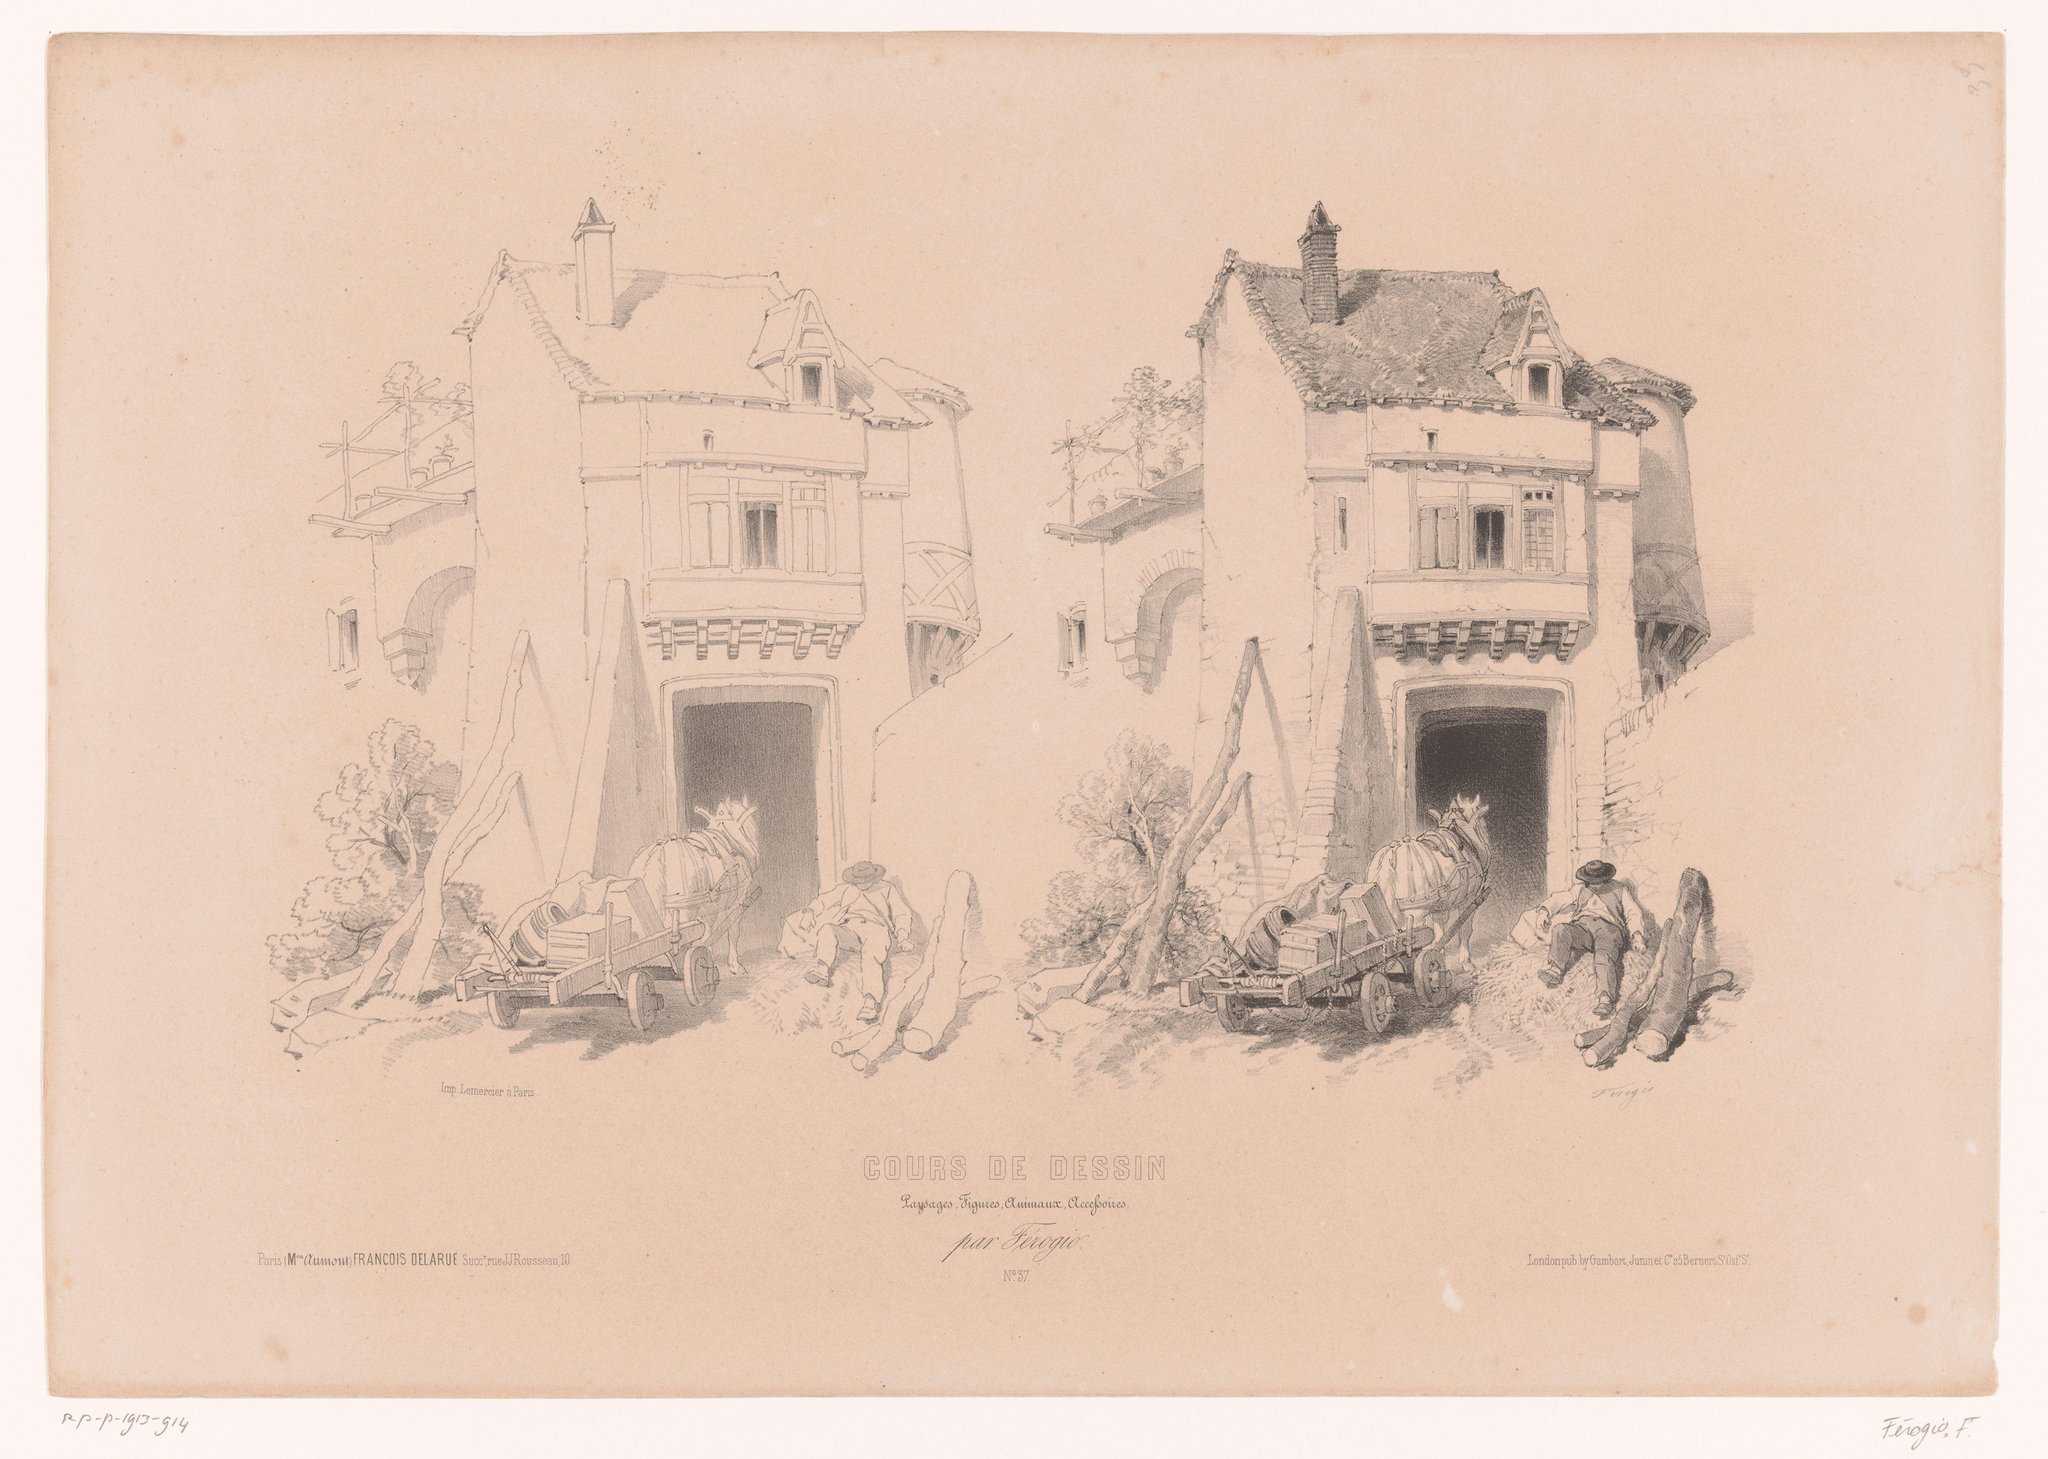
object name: print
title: Vrachtrijder met paard en wagen rust bij een poort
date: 1845-1846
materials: paper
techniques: lithograph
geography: london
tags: riding a horse, ass, or mule; rider, horseman, four-wheeled vehicle drawn by one animal, gate, entrance, resting - bb - out of doors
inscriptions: collector's mark: Lugt 2228a